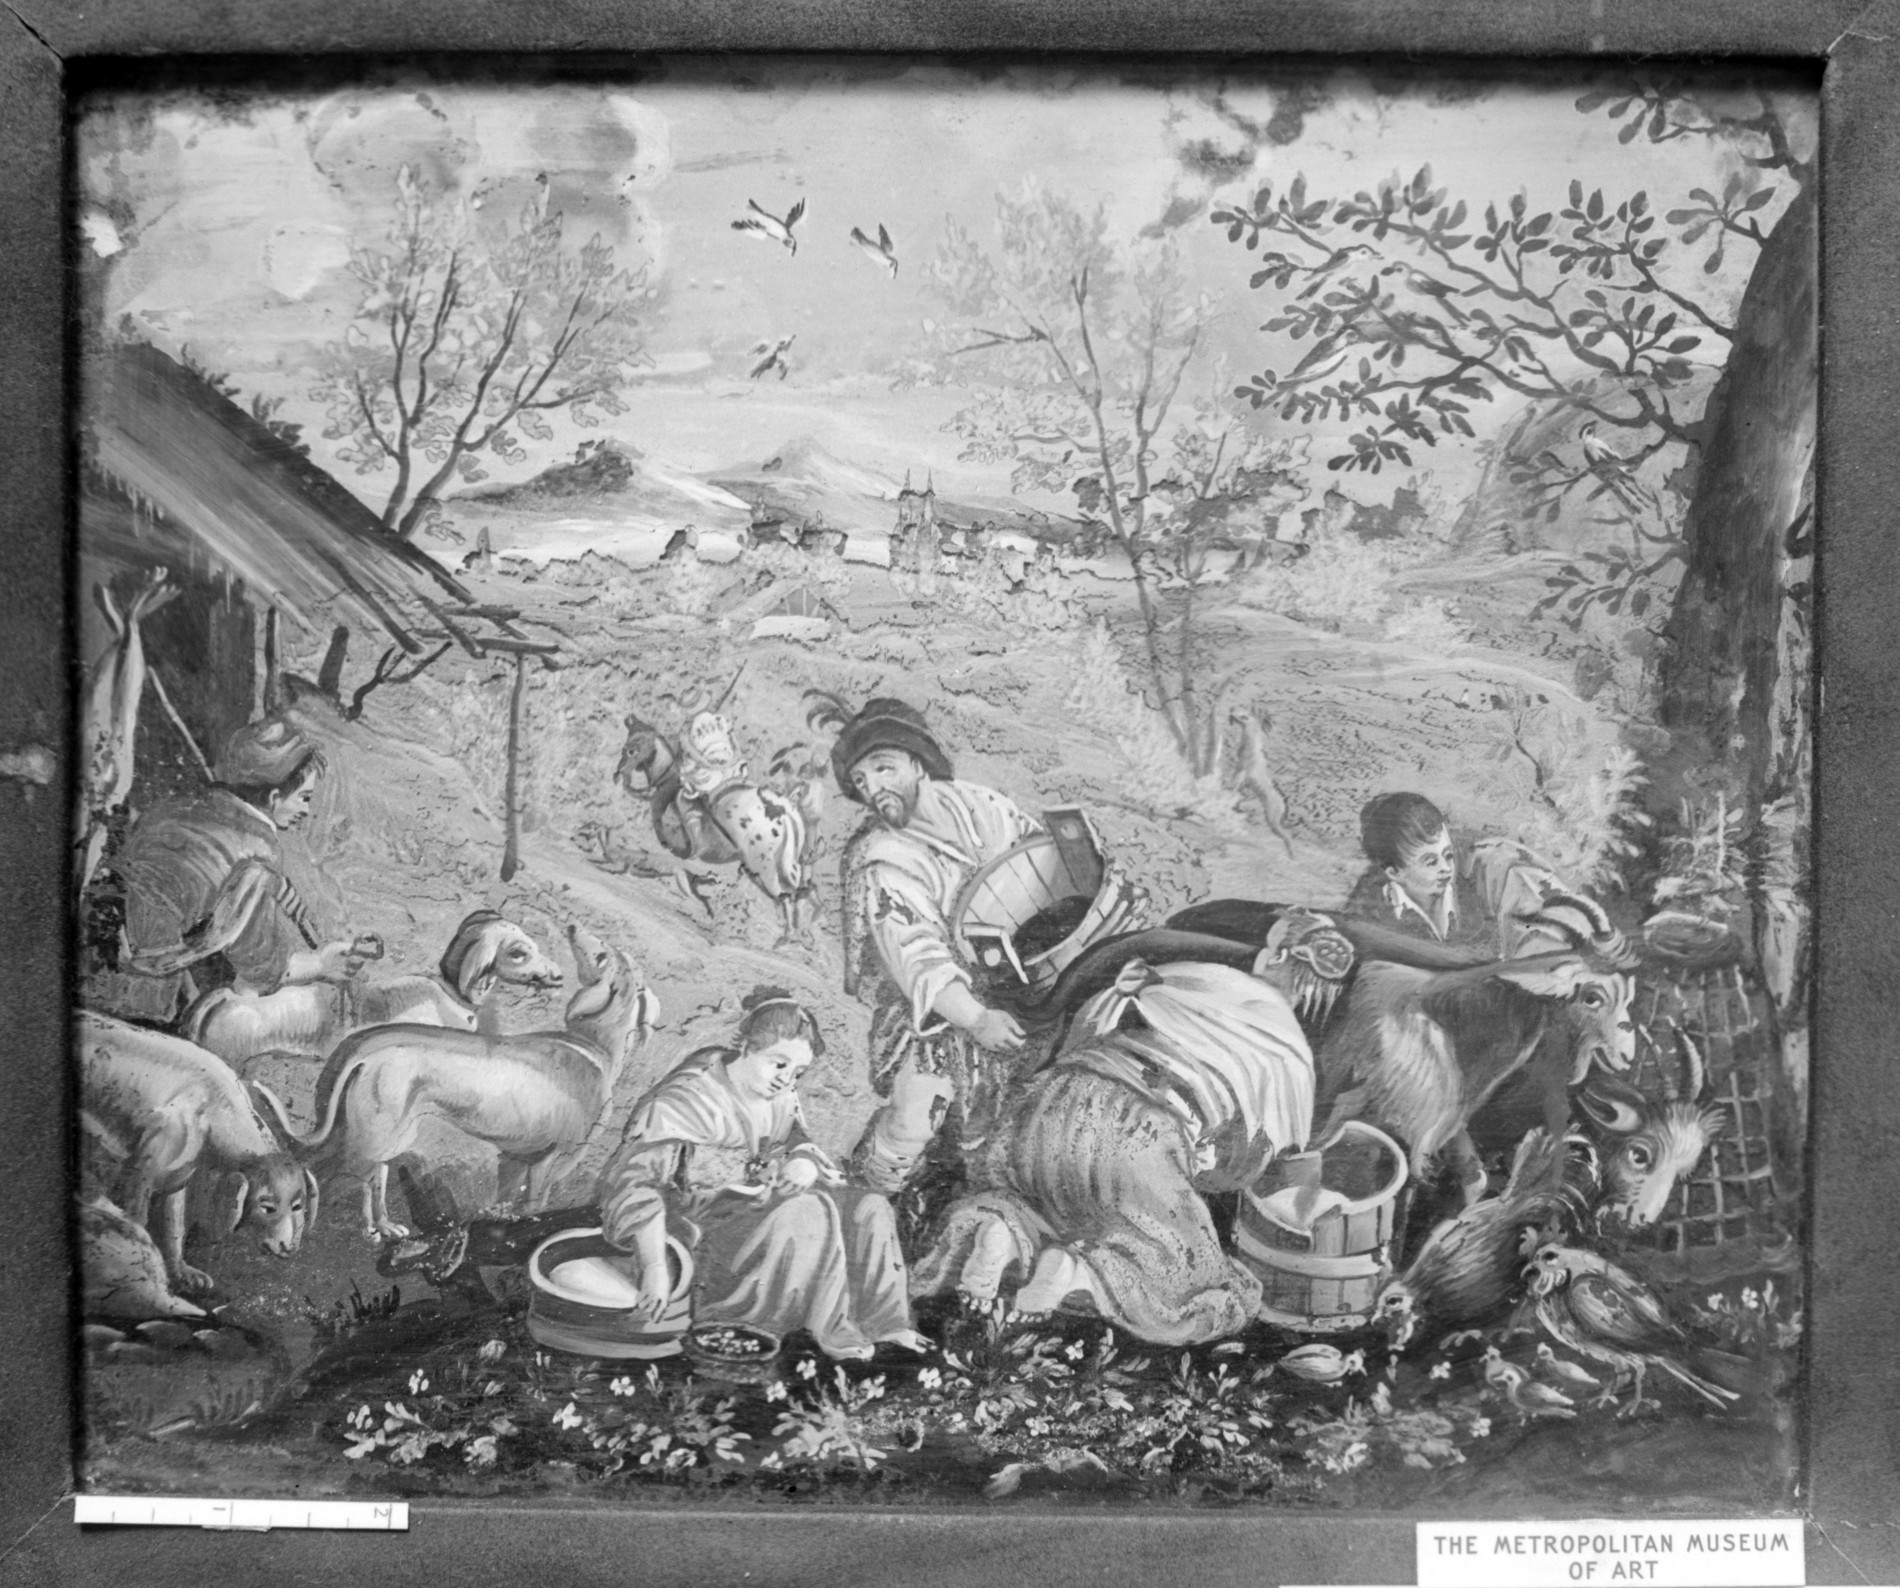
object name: panel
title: Bucolic scene in spring with goat milking (one of a pair)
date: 1667-1700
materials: glass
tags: human figures,goats,pastoral,spring,working